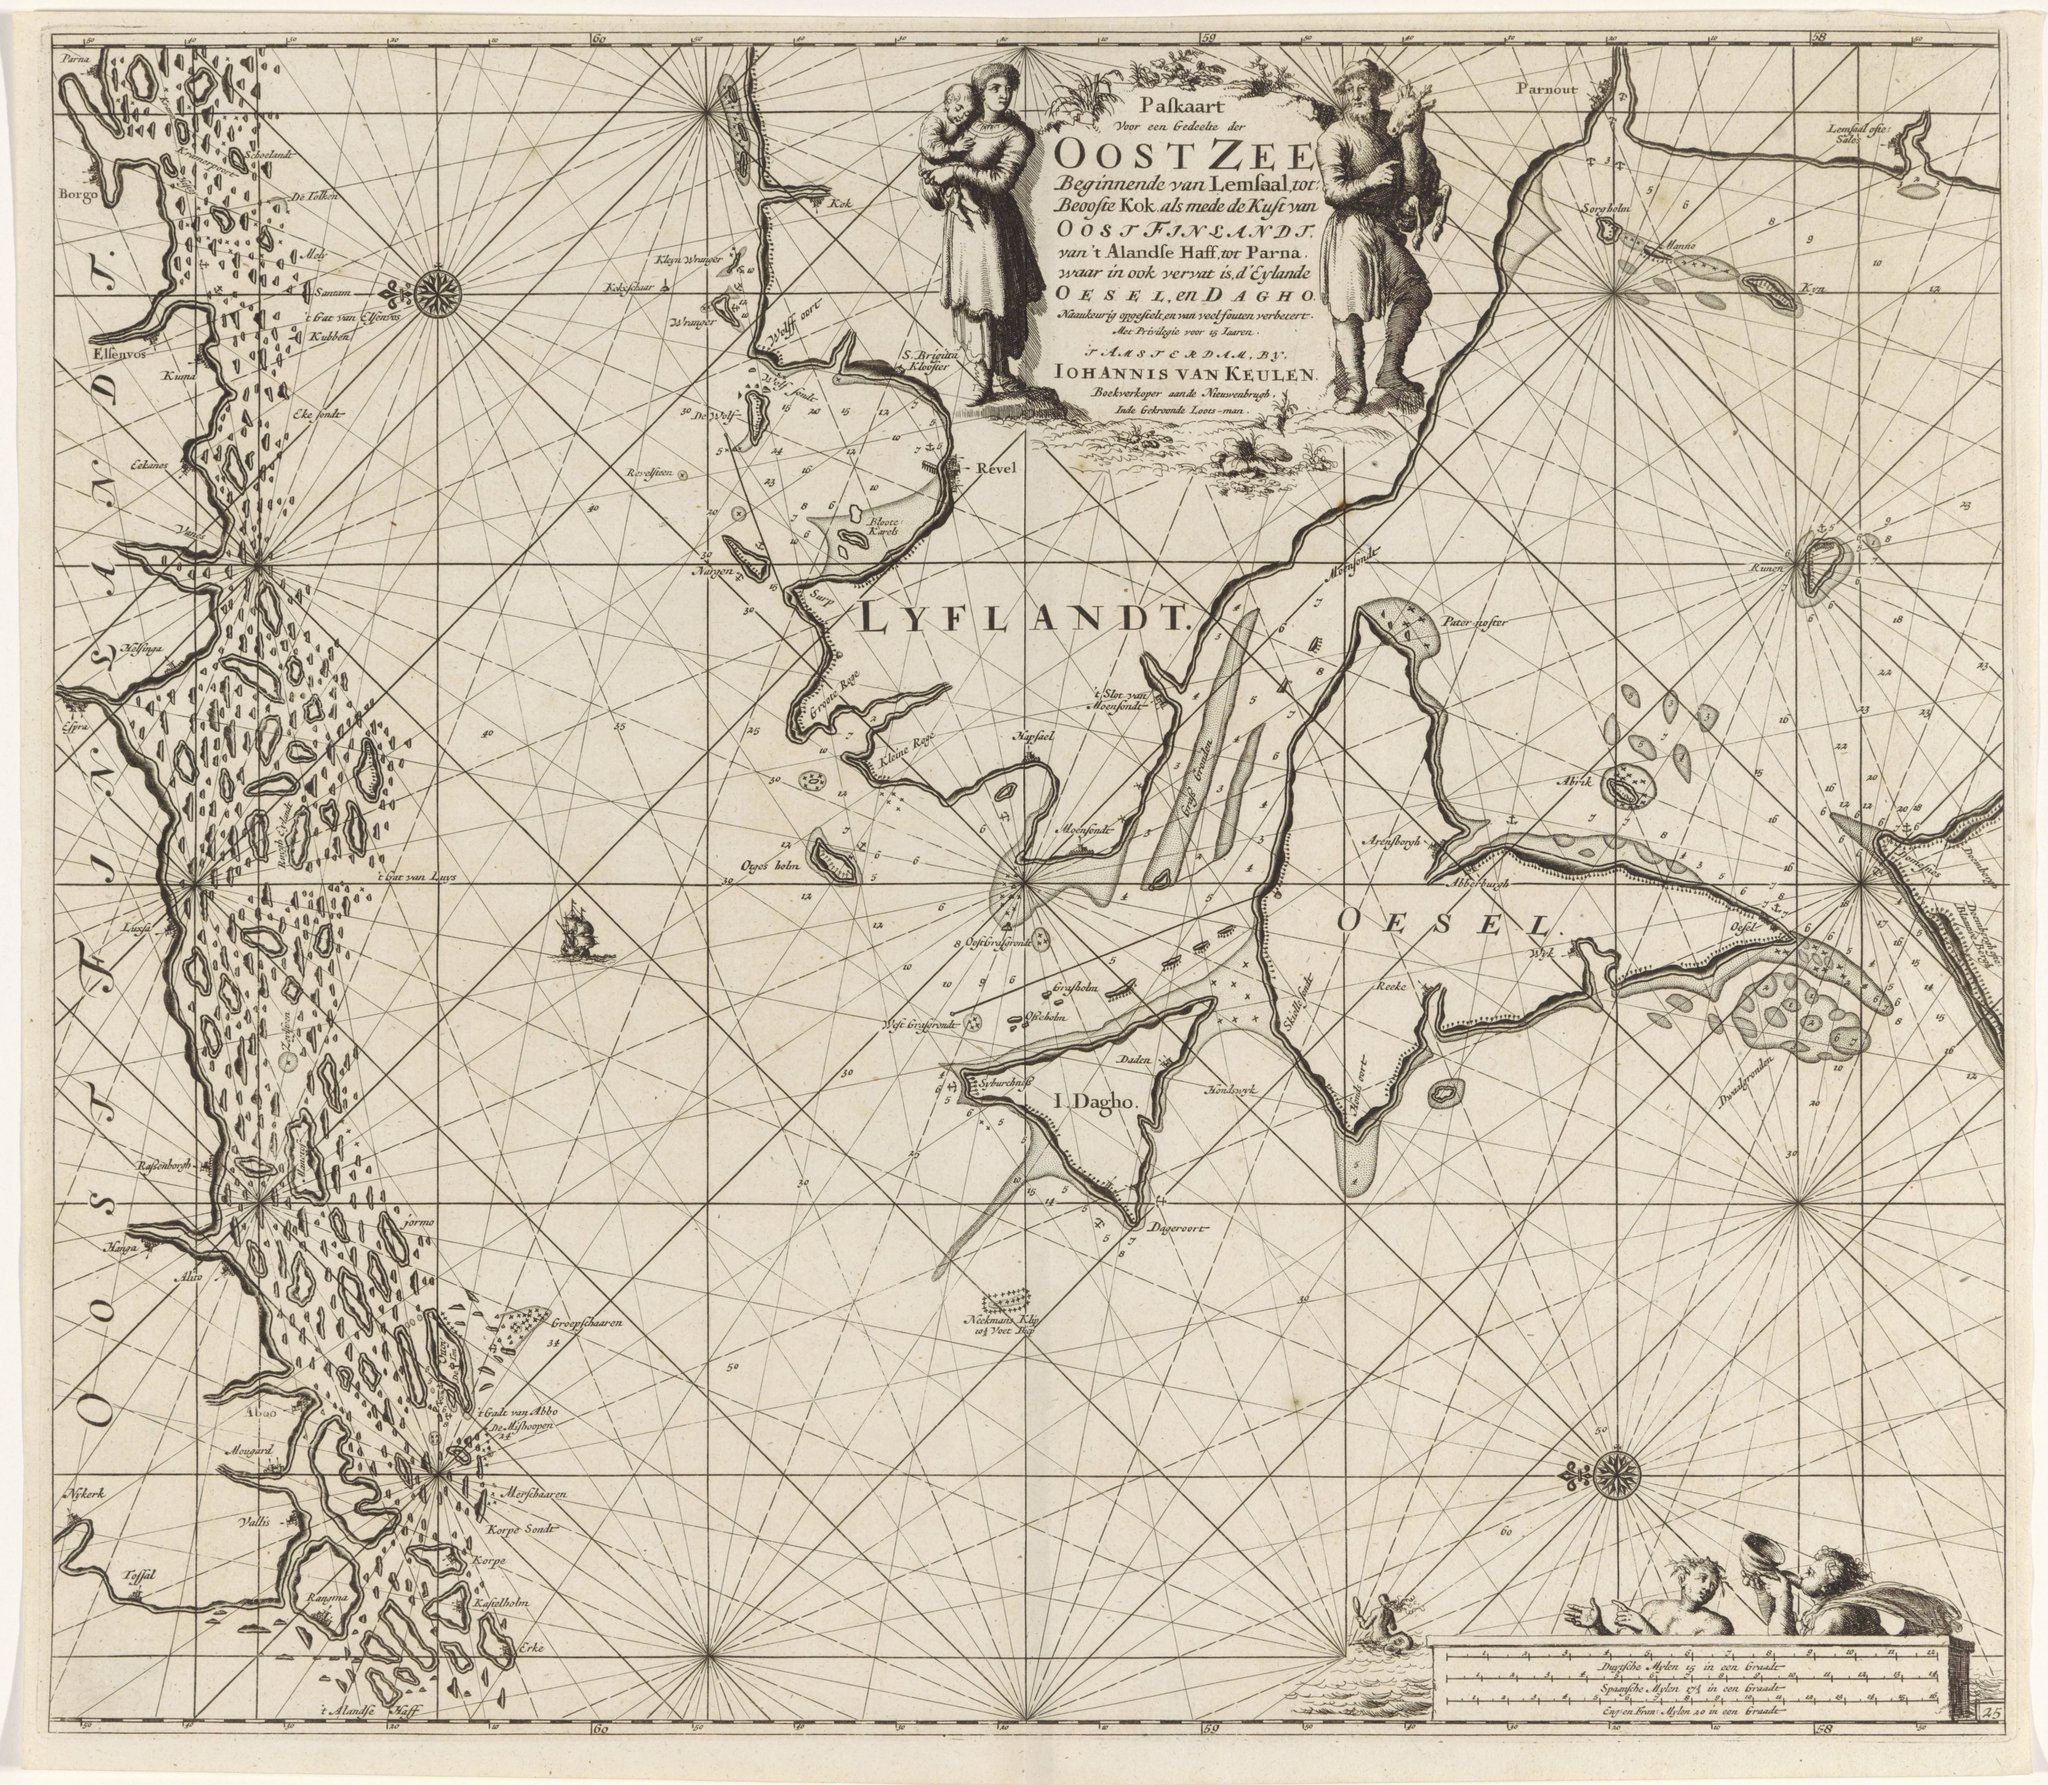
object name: print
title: Paskaart van de monding van de Finse Golf in de Oostzee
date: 1681-1799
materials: paper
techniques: engraving, etching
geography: amsterdam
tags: hoofed animals: deer, merman - aa - mermaid, siren, mother and baby or young child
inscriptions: collector's mark: Lugt 2228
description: Paskaart van de monding van de Finse Golf in de Oostzee, met twee kompasrozen, het Noorden ligt rechts. Bovenaan een cartouche met de titel en het adres van de uitgever, geflankeerd door een vrouw met een jong kind en een man met een jong hert. Rechtsonder een zeemeermin en twee zeegoden bij de schaalverdeling in Duitse, Spaanse en Engelse of Franse mijlen (c. 1:600.000).